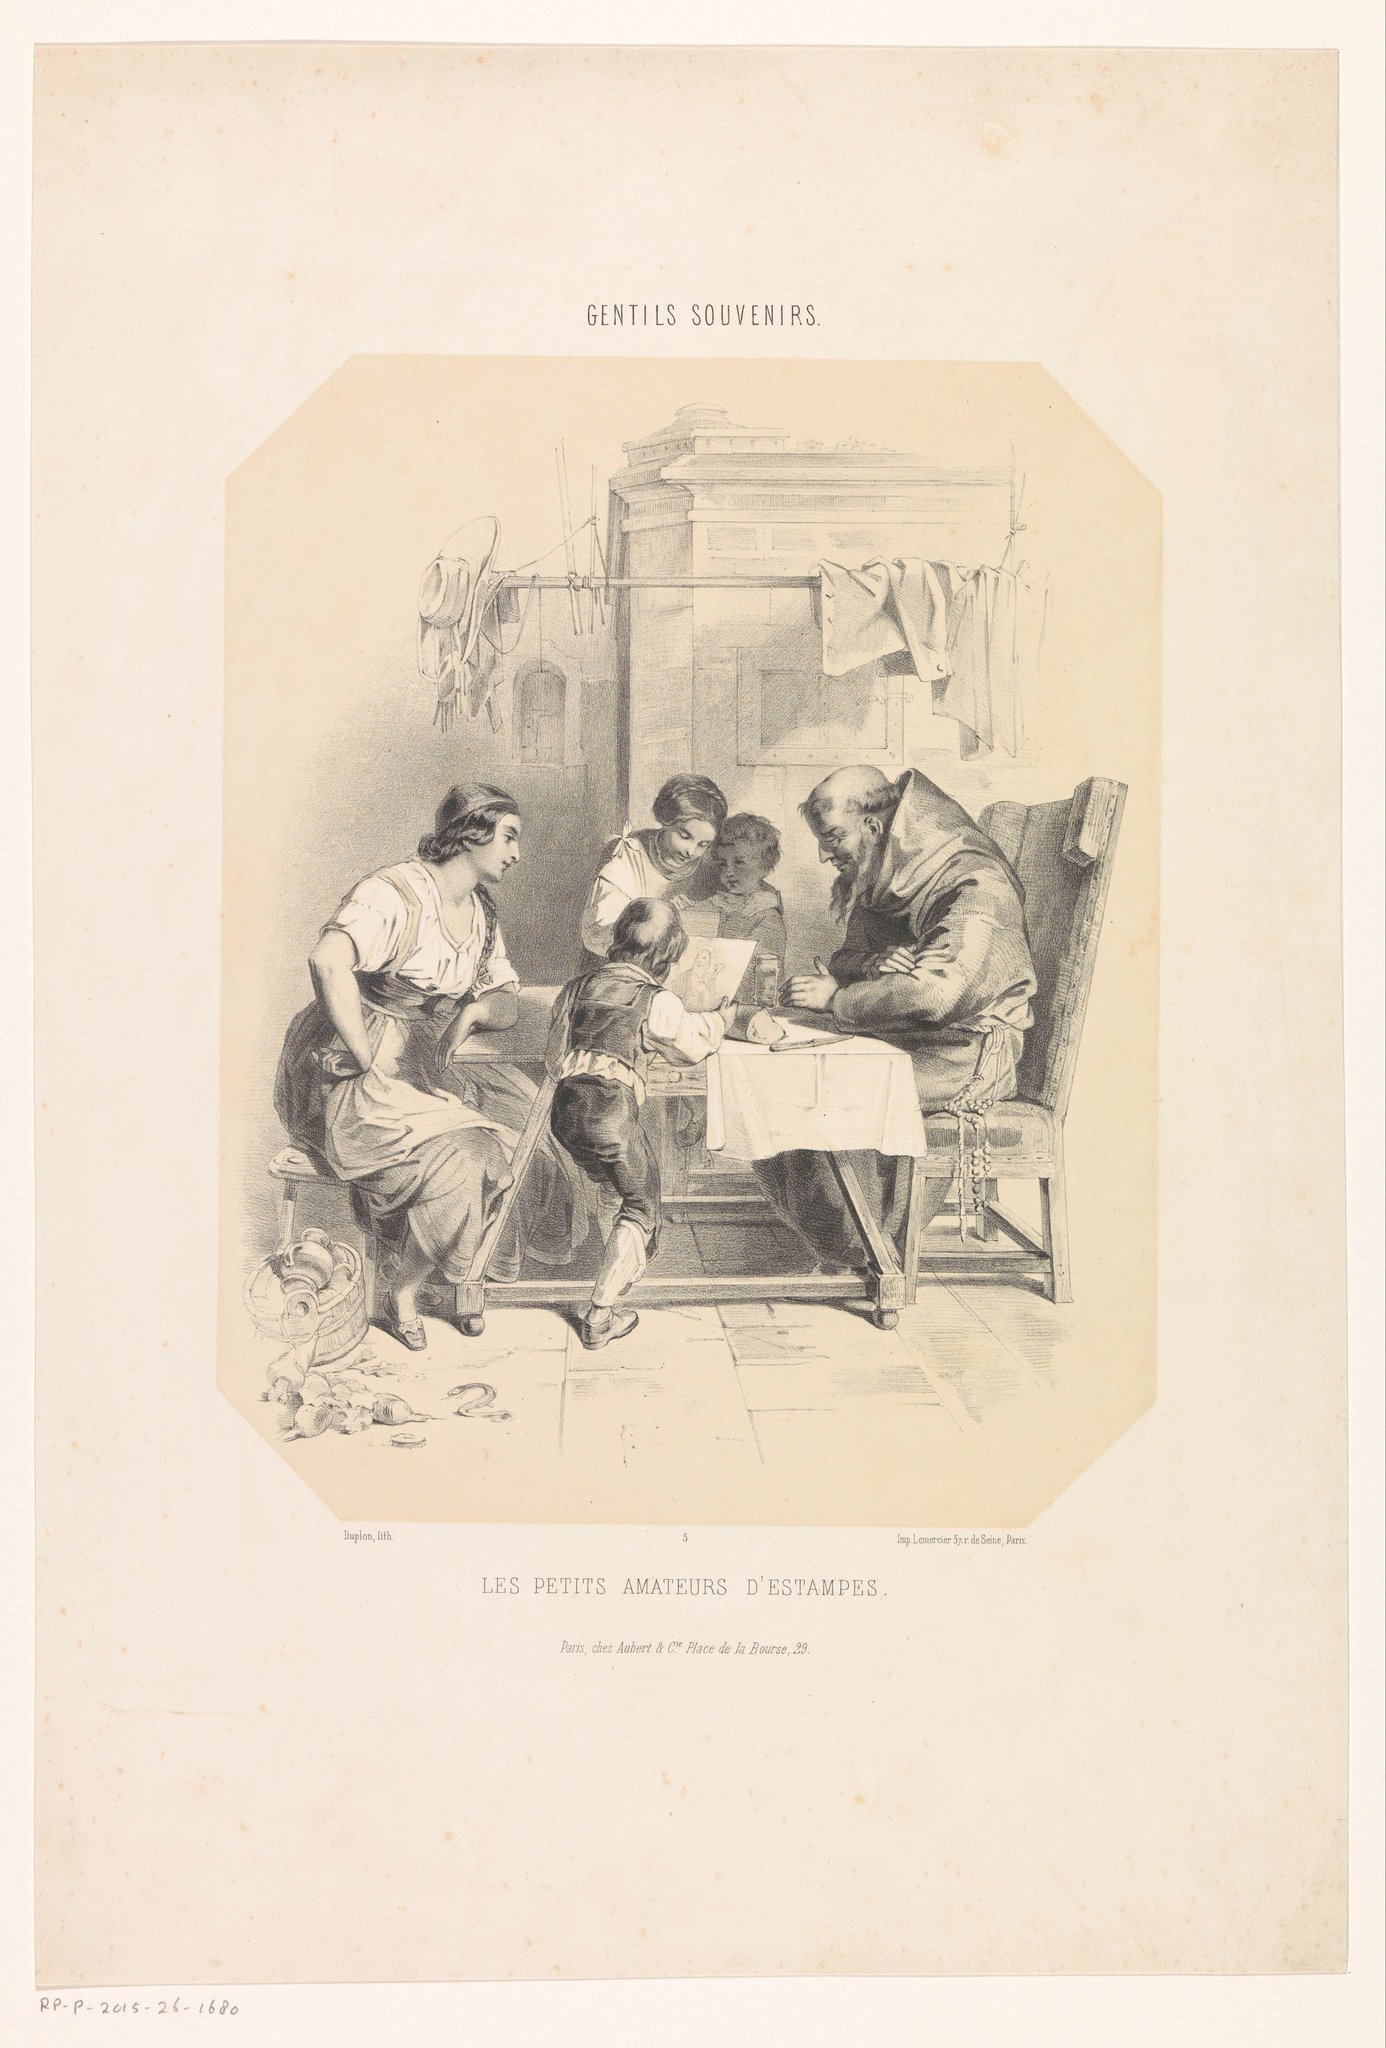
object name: print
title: Gentils souvenirs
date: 1841-1848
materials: paper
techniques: tone lithography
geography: paris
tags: print, e.g.: engraving, etching, lithograph, monk(s), friar(s)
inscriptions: collector's mark: Lugt 2228, collector's mark: Lugt 4779, collector's mark: Lugt 4780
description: Rond een tafel zitten twee vrouwen, twee kinderen en een monnik. De kinderen bekijken religieuze prenten.